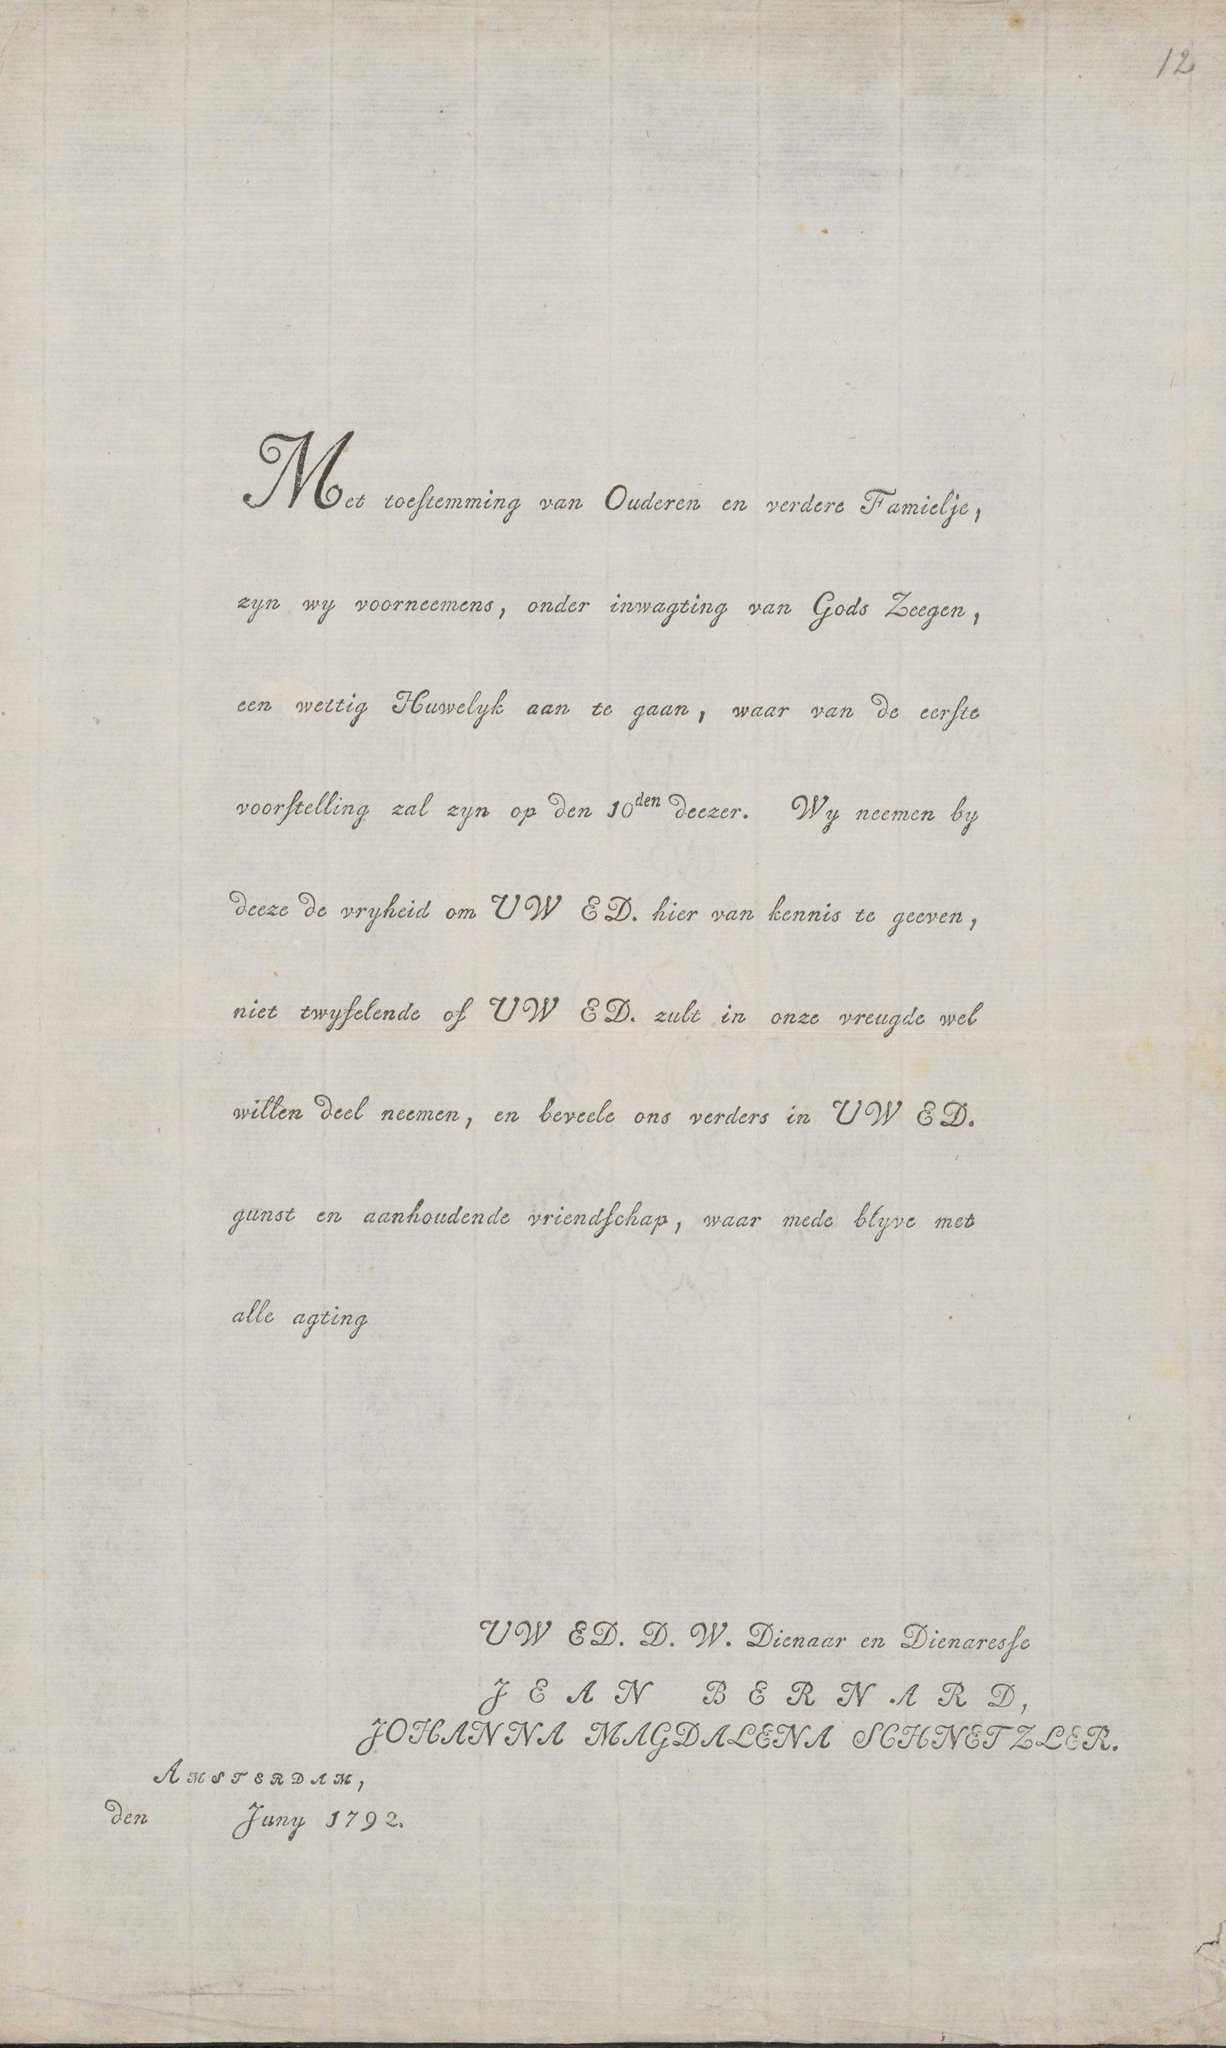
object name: wedding announcement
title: Huwelijksaankondiging van Jean Bernard en Johanna Magdalena Schnetzler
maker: Anonymous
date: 1706-1792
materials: paper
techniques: printing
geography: amsterdam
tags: print maker, draughtsman, jean bernard, johanna magdalena schnetzler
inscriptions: collector's mark: Lugt 2233, watermark